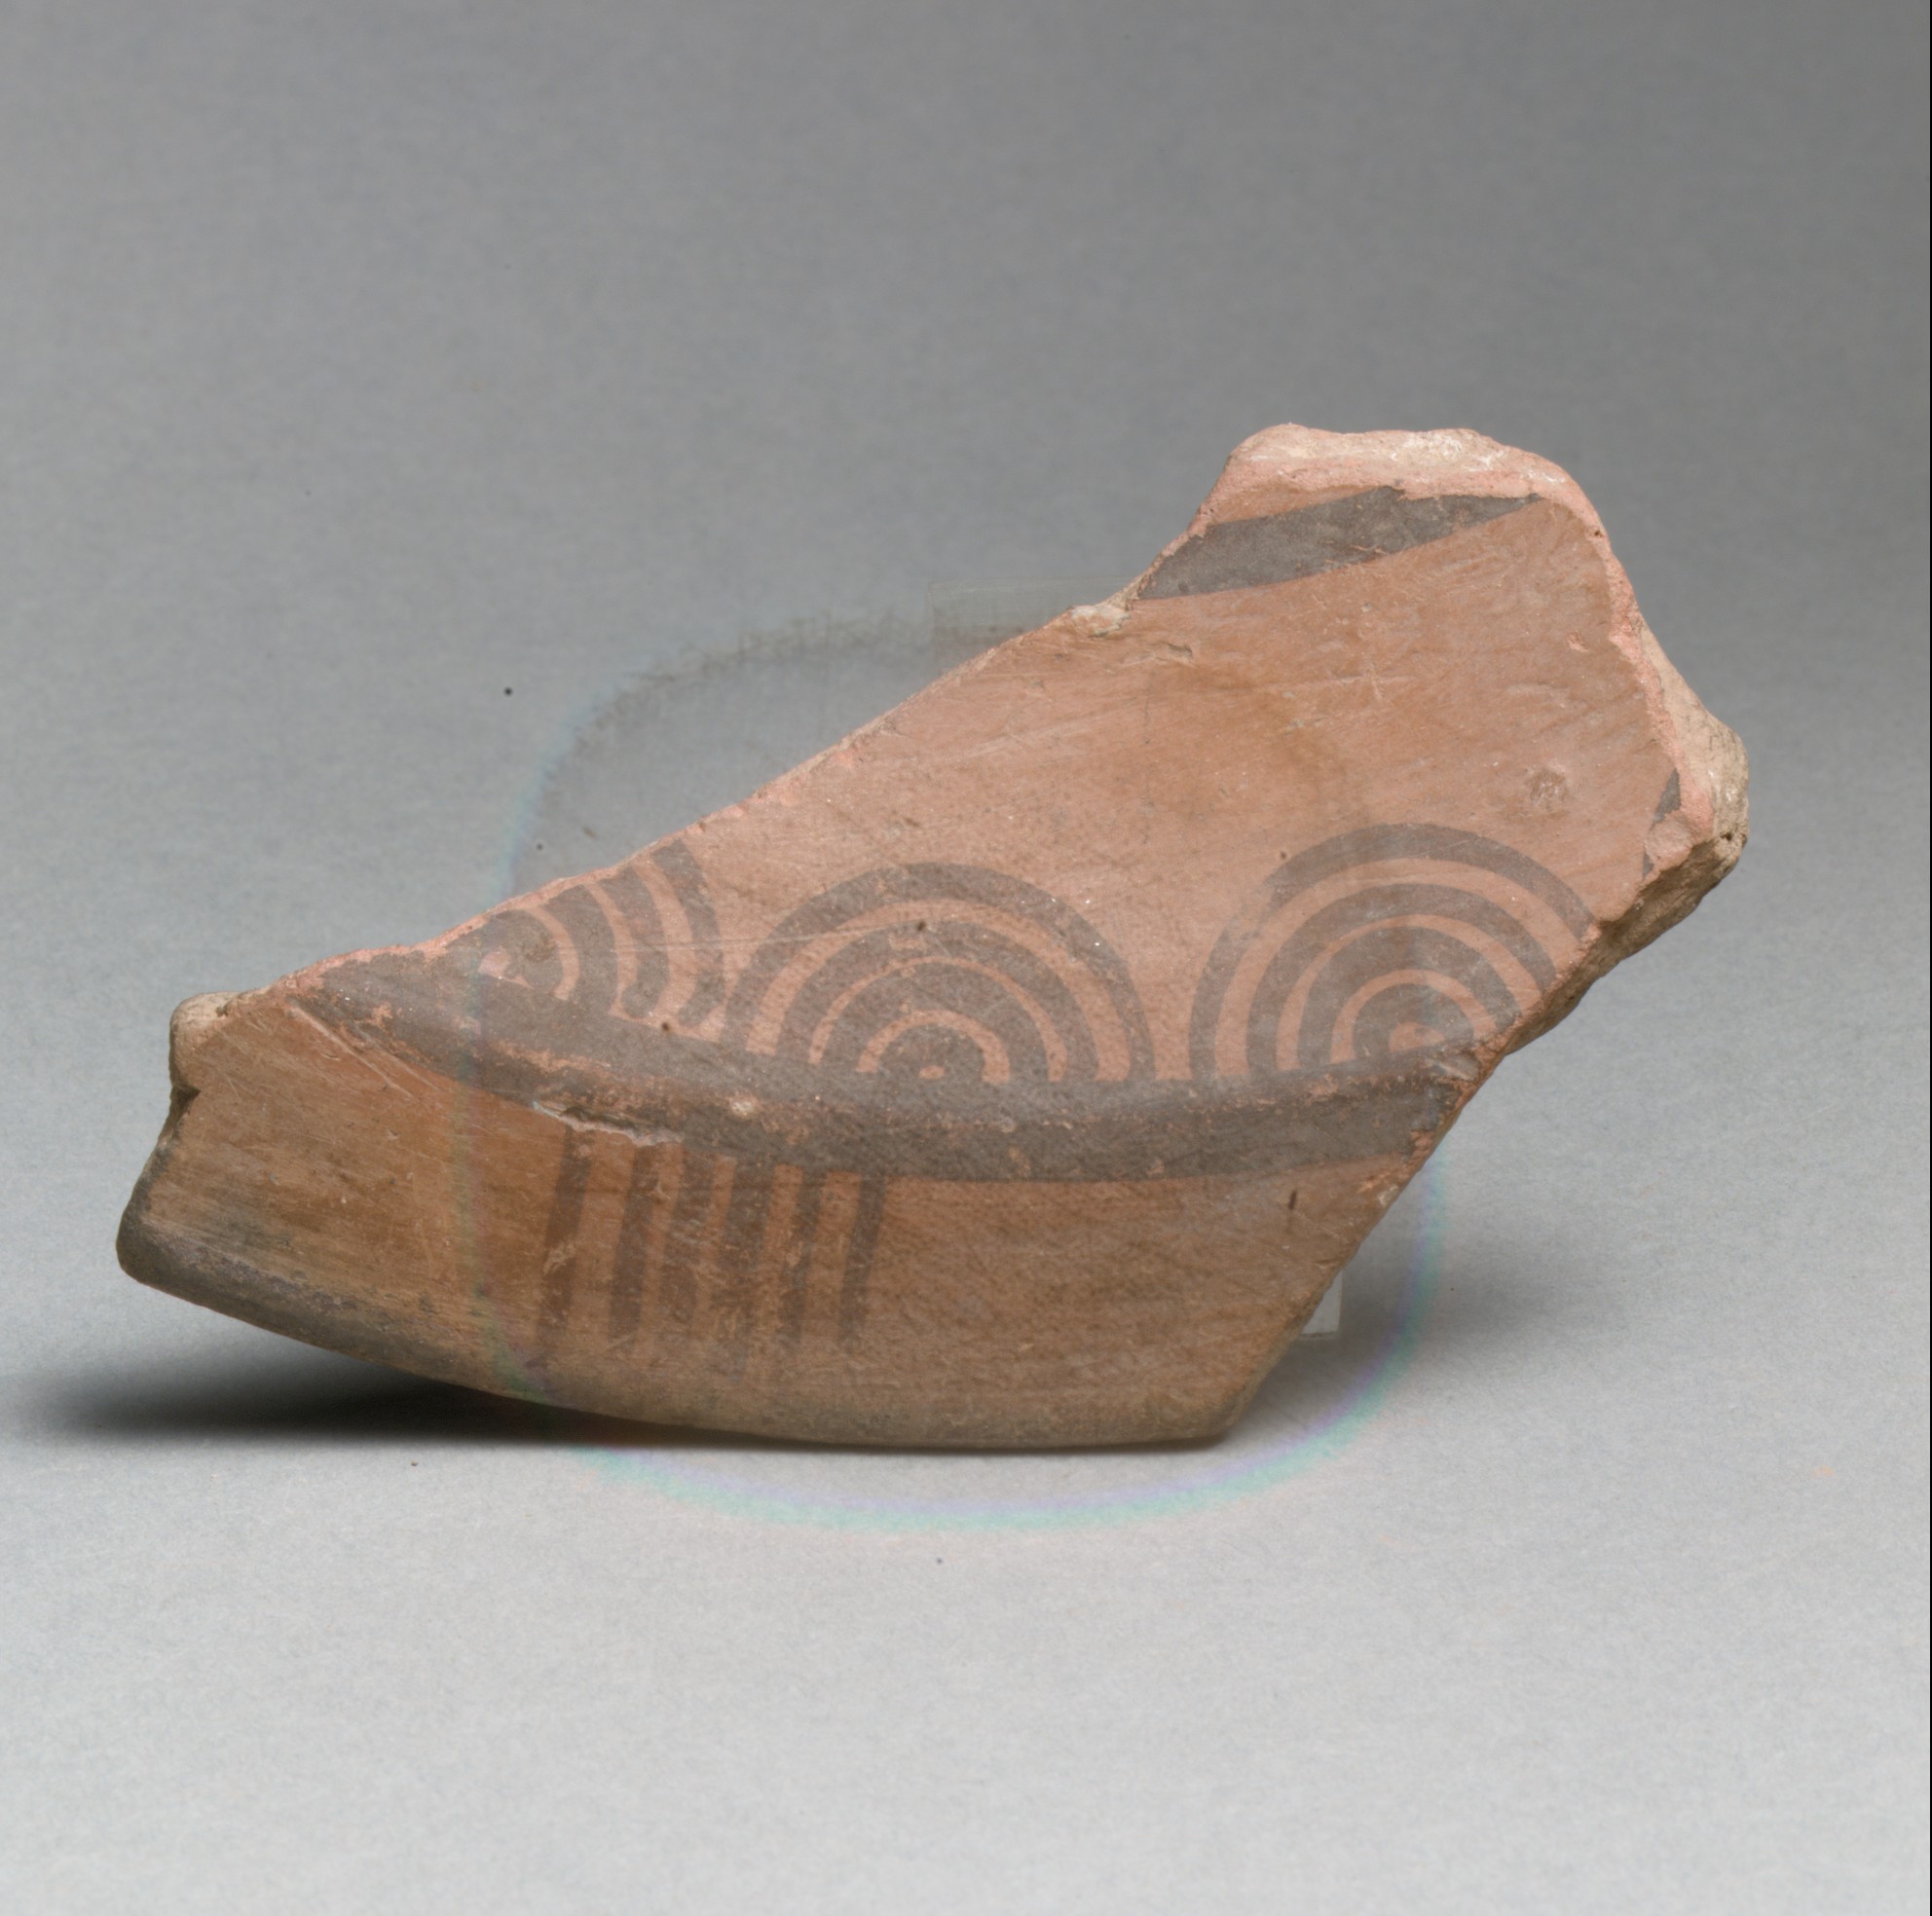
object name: vase fragment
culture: greek or lydian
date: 1050-700 BCE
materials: terracotta